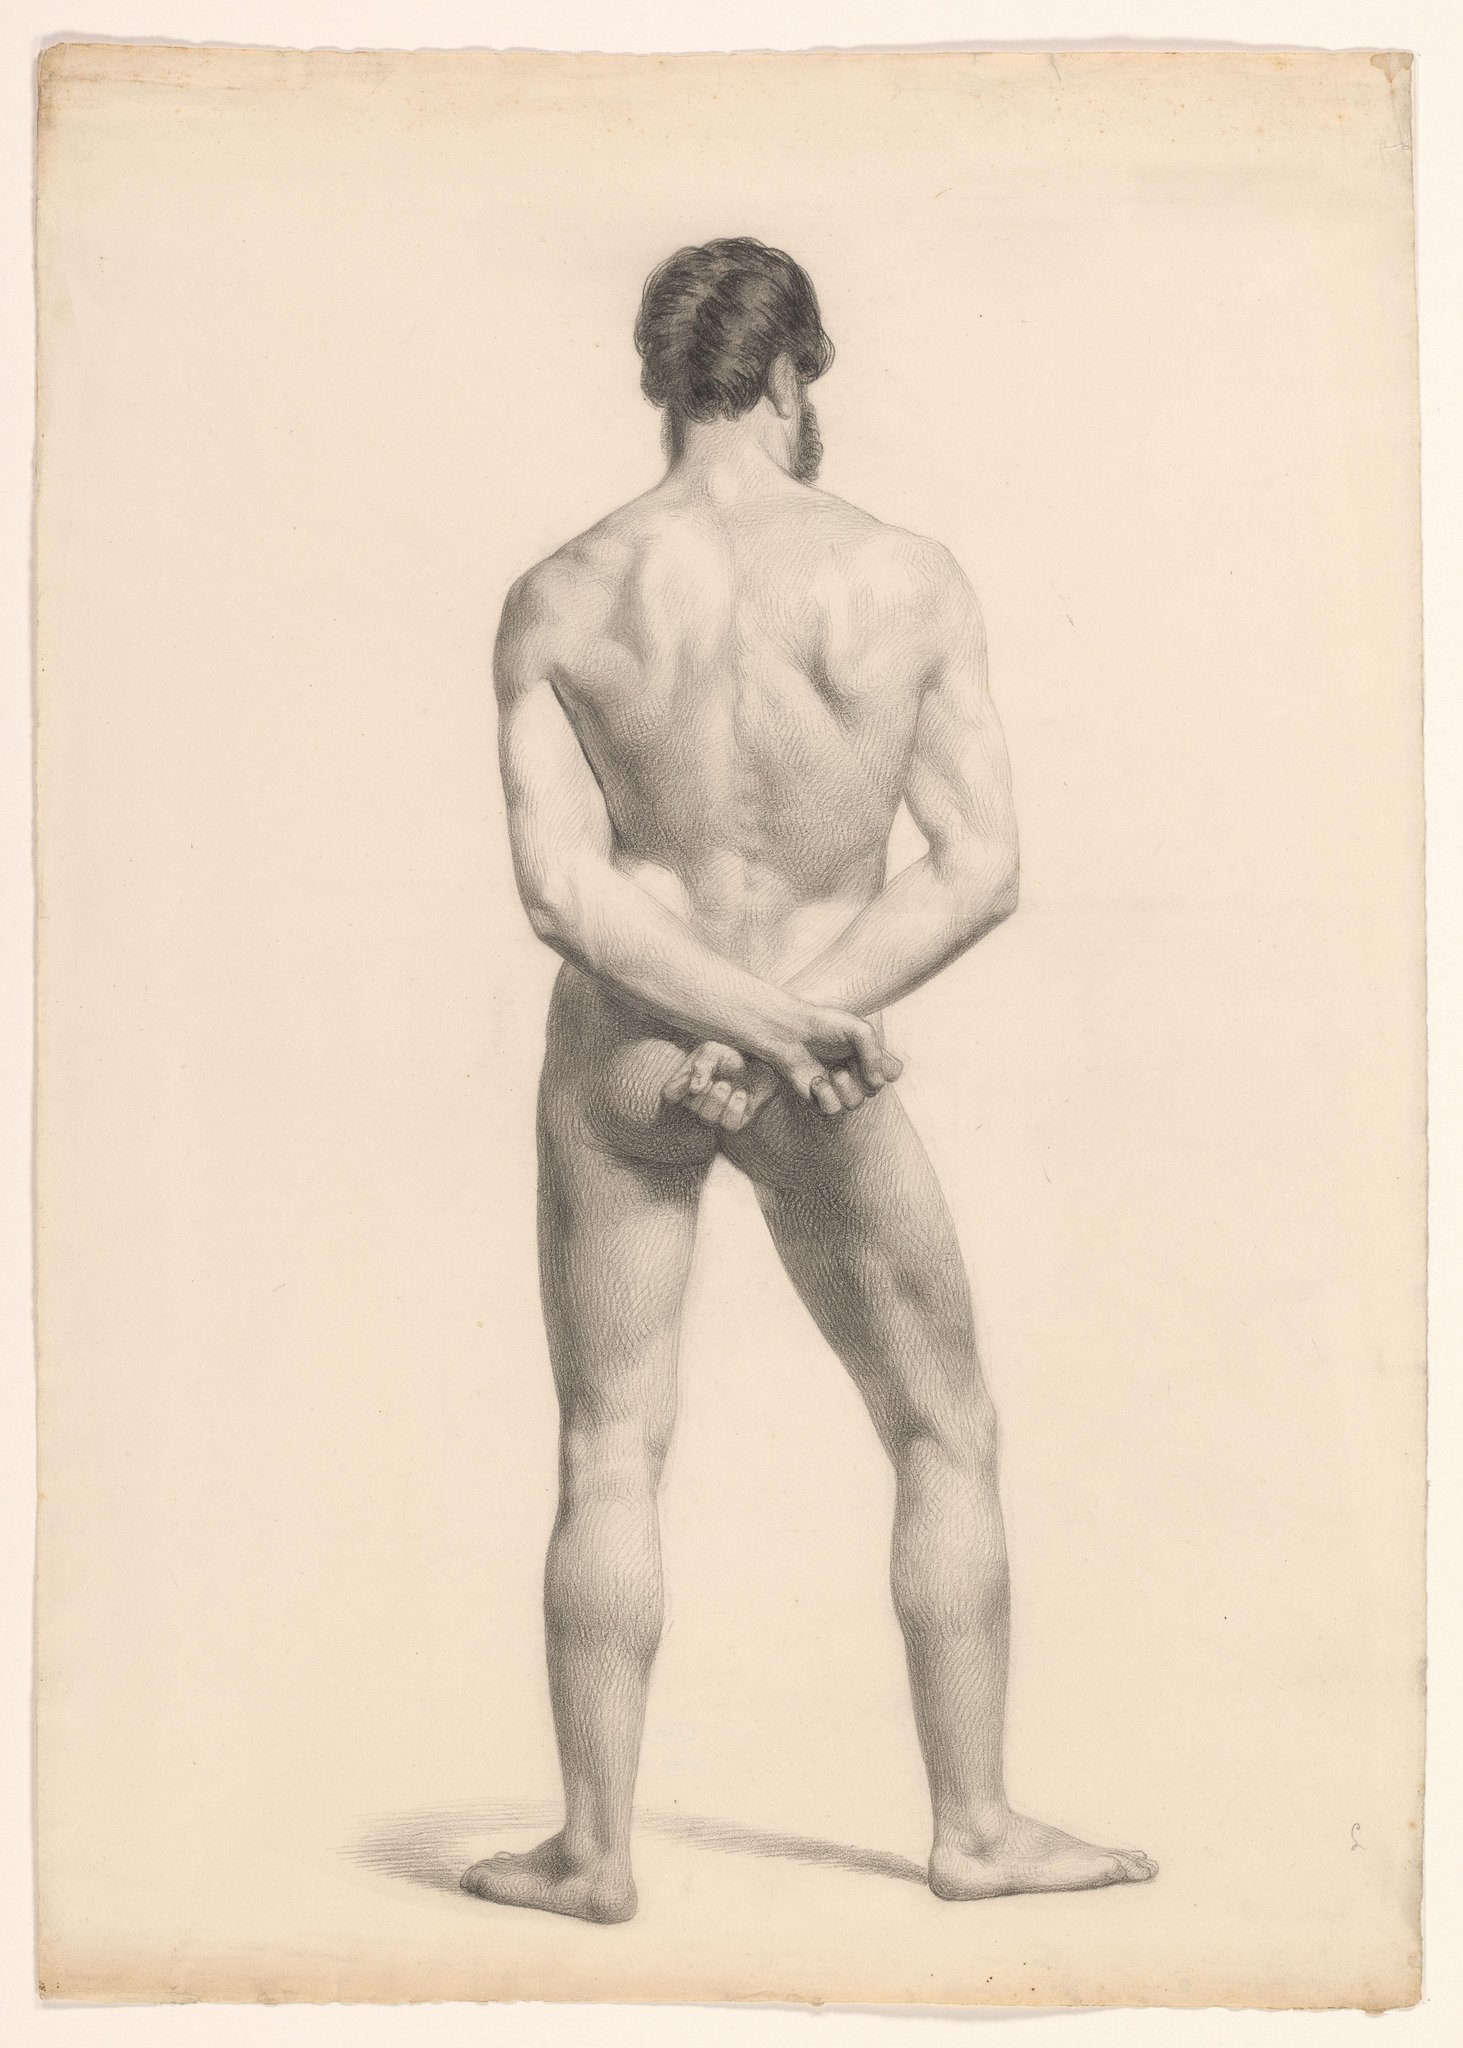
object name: drawing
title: Academiestudie naar staand mannelijk naakt, op de rug gezien met de handen op de rug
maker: jacobus everhardus josephus van den berg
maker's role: draughtsman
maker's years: 1802-1861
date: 1812-1861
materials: chalk, paper